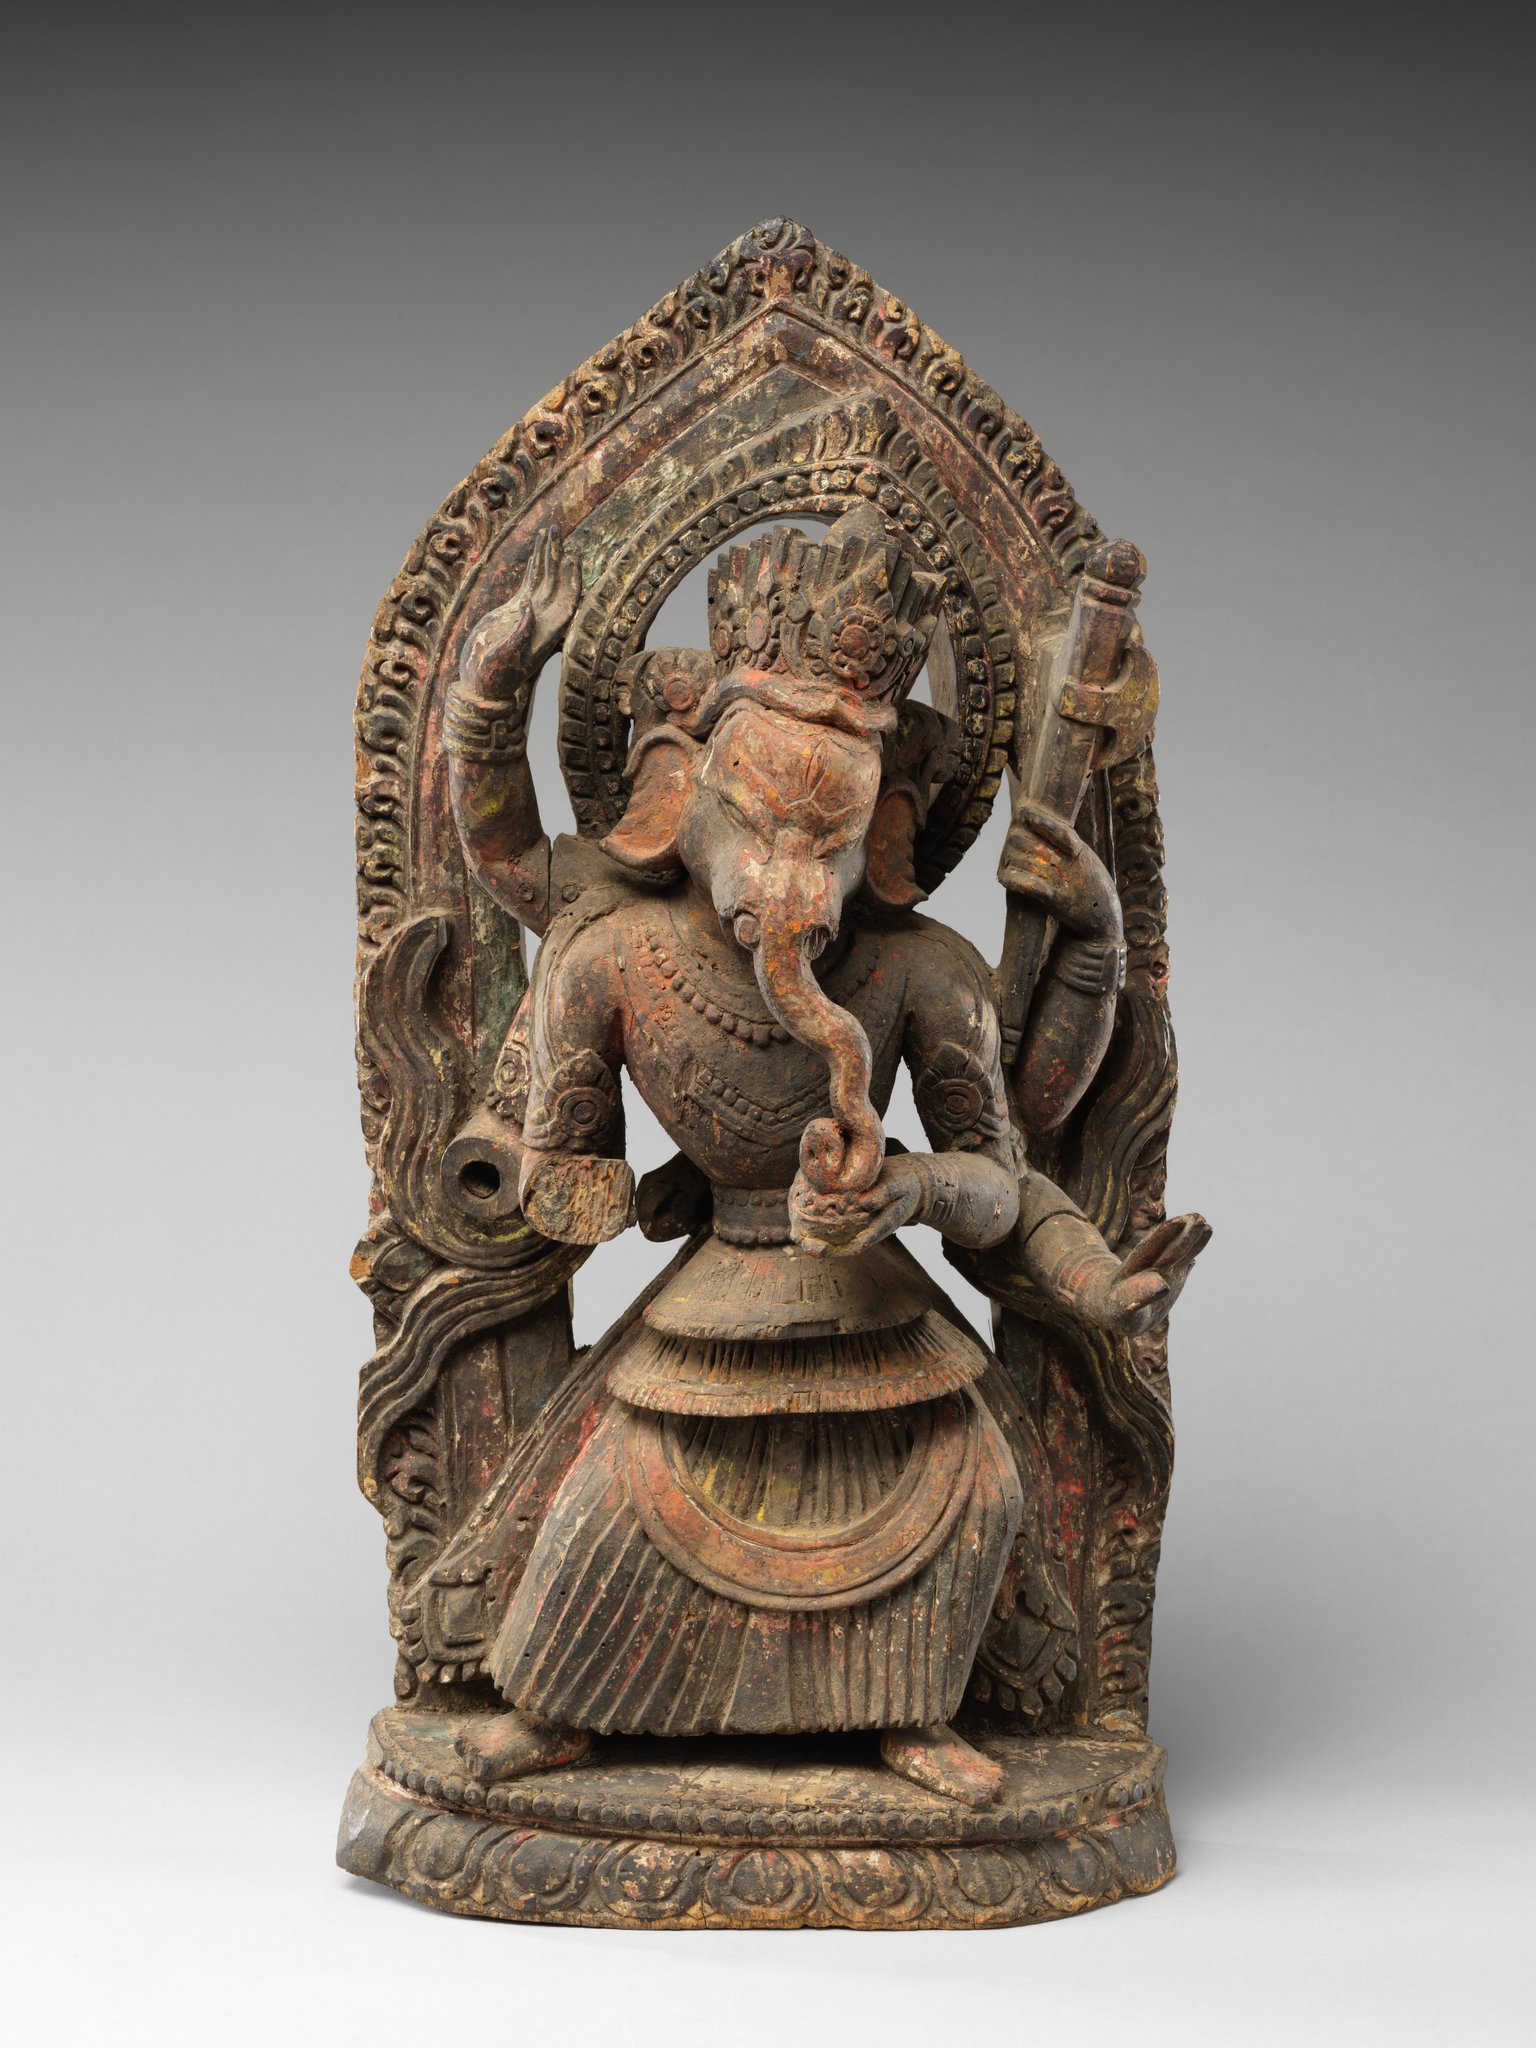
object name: figure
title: Standing Ganesha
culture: nepali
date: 1501-1700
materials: wood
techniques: polychrome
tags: ganesha